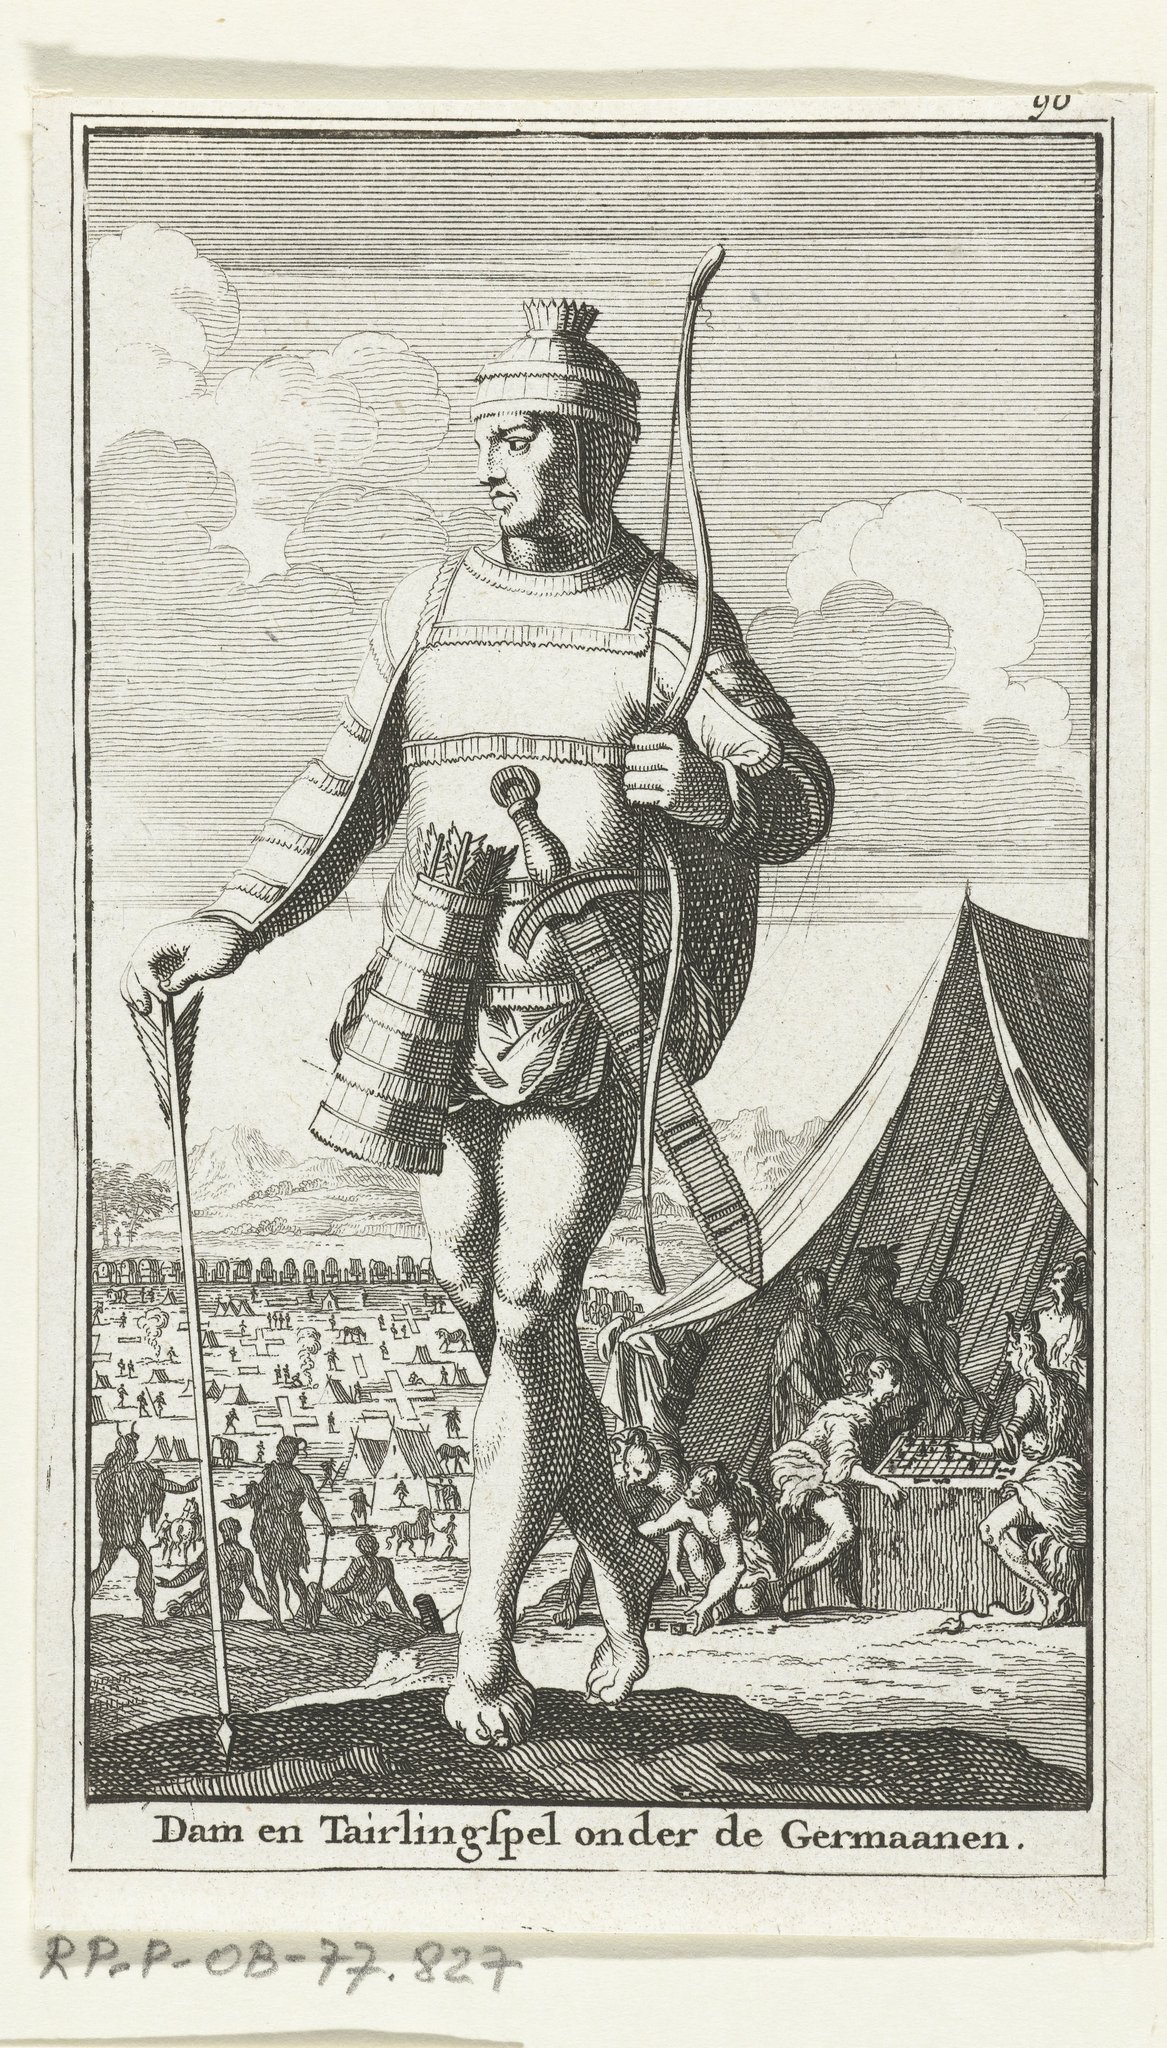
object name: history print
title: Dam en Tairlingspel onder de Germaanen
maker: Anonymous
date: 1712-1714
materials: paper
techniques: etching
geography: netherlands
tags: games of skill, extinct, 'historical' peoples (with name), netherlands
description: Gebruikt als illustratie in: Hugo de Groots Antiquitates Germanicæ, of Hoogduitsche oudtheden: waar in de gelegentheid en zeeden der Germaanen, beschreeven door Tacitus, naaukeurig verklaart, en met printverbeeldingen opgeheldert worden: benevens H. Grotius verhandeling van de oudtheid der Batavische republyk. Amsterdam: Jacob van Royen, 1714. Er zijn geen bronnen bekend waaruit blijkt dat de Germanen het damspel kenden. De Romeinen speelden alleen het latrunculispel (soldatenspel).